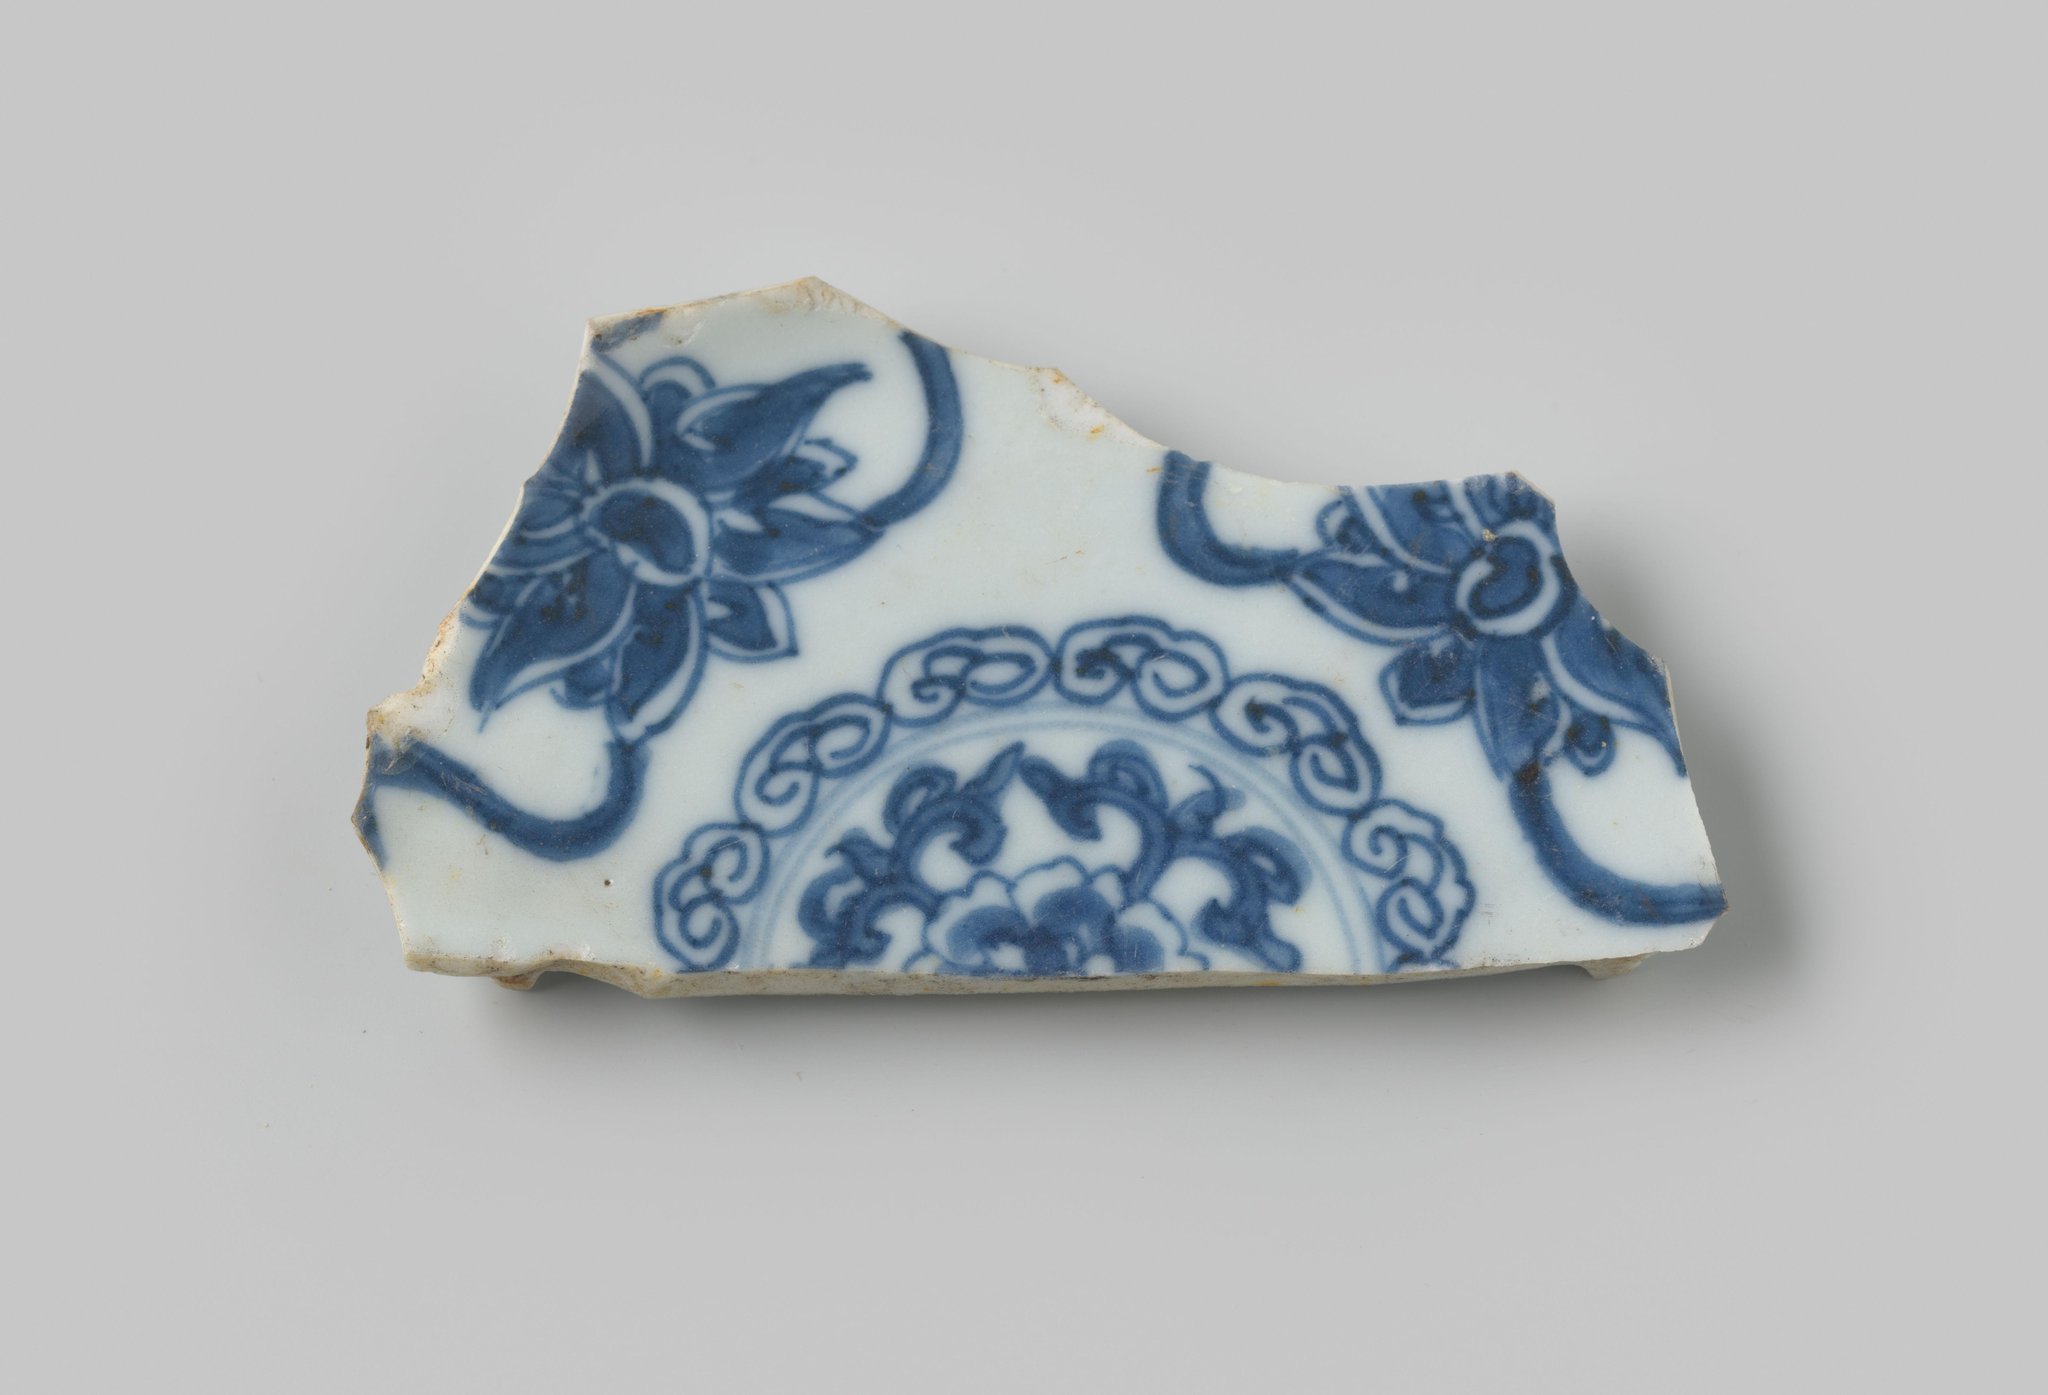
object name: platter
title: Bodemfragment van een schotel uit het wrak van de Oost-Indiëvaarder Hollandia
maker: Anonymous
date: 1700-1743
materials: porcelain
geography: netherlands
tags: verenigde oostindische compagnie, hollandia (schip)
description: Porcelain, saucer, type 2; fragm of base, sim. 79-209H1318.